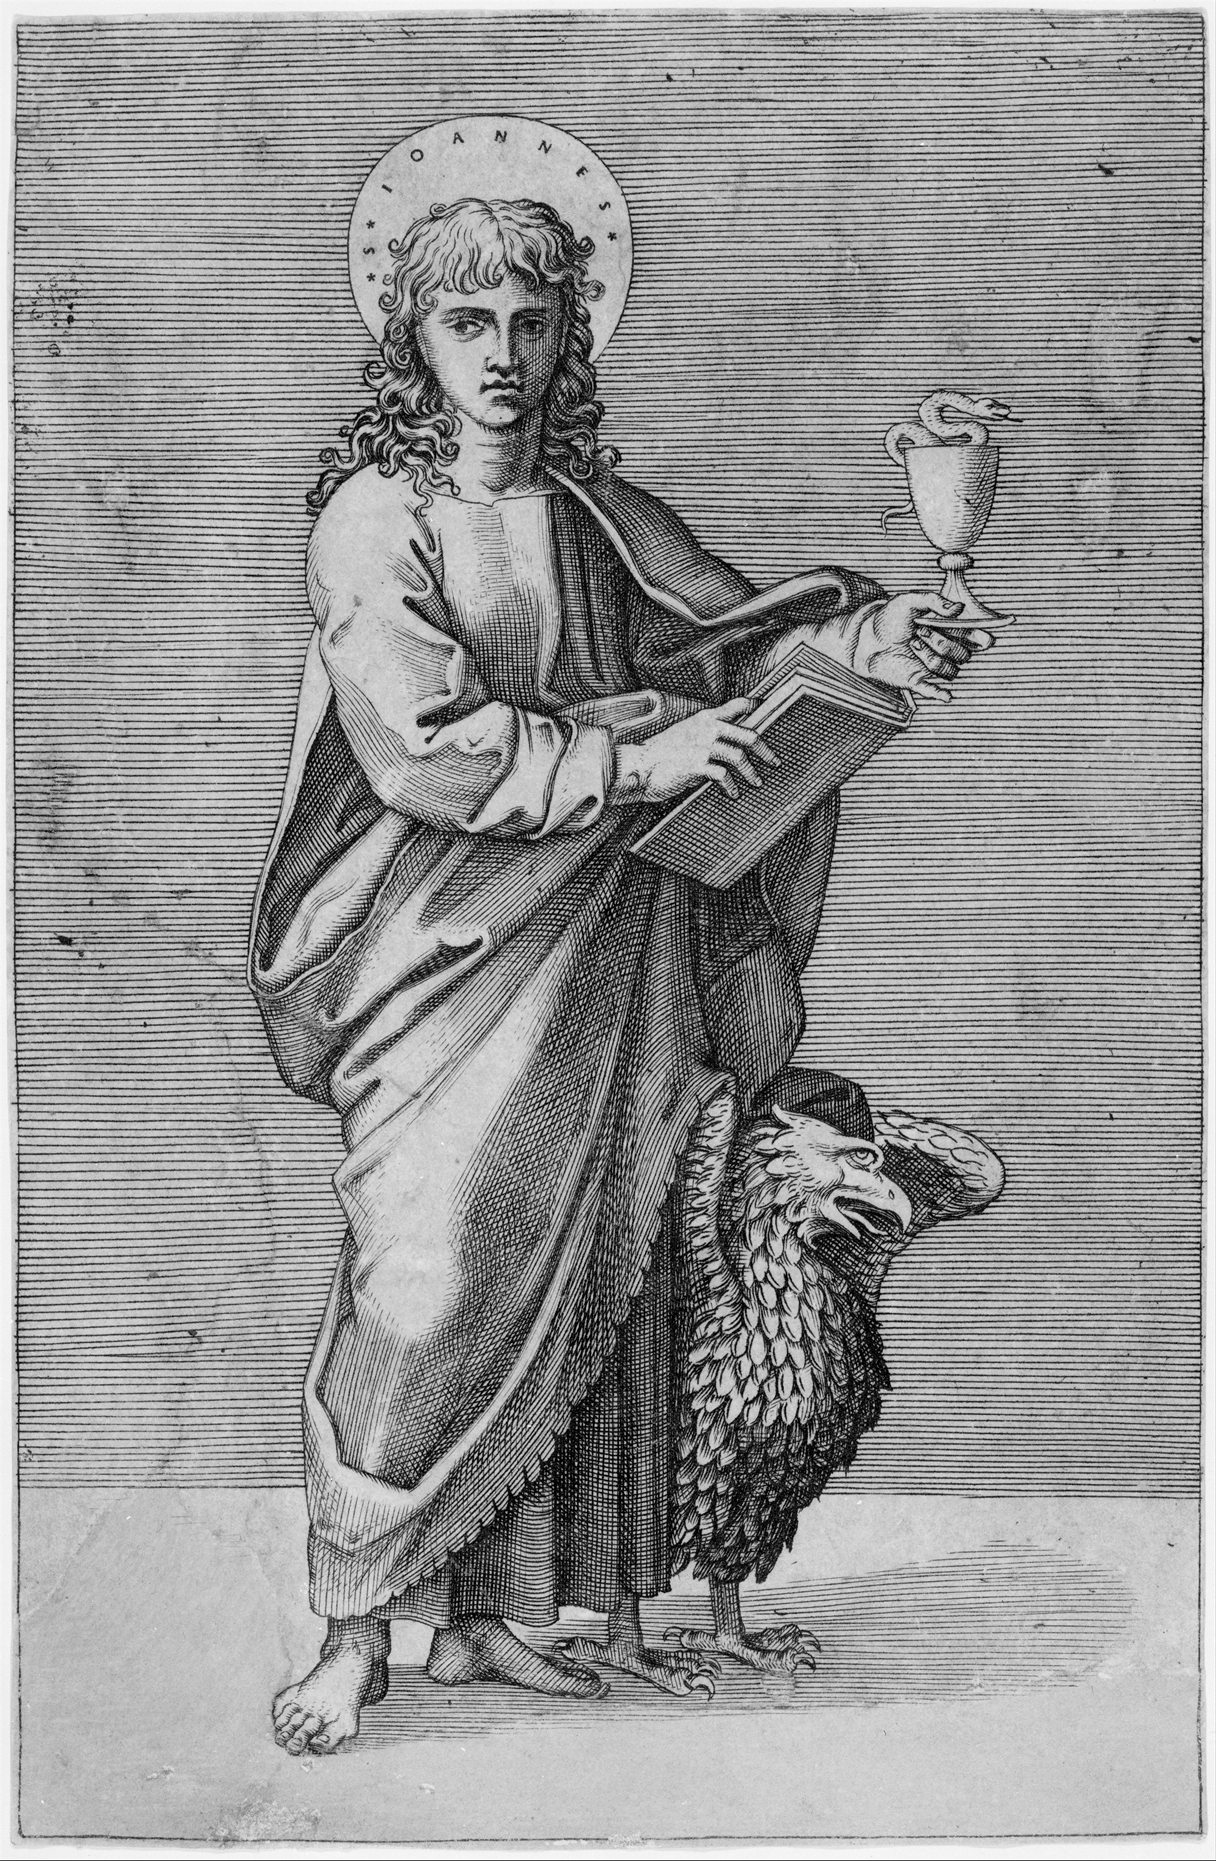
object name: print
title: Saint John holding chalice in left hand, book in right, eagle standing by left side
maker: marcantonio raimondi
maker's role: artist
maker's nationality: italian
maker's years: 1475-1534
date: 1500-1550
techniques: engraving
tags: eagles,books,saint john the baptist,chalices